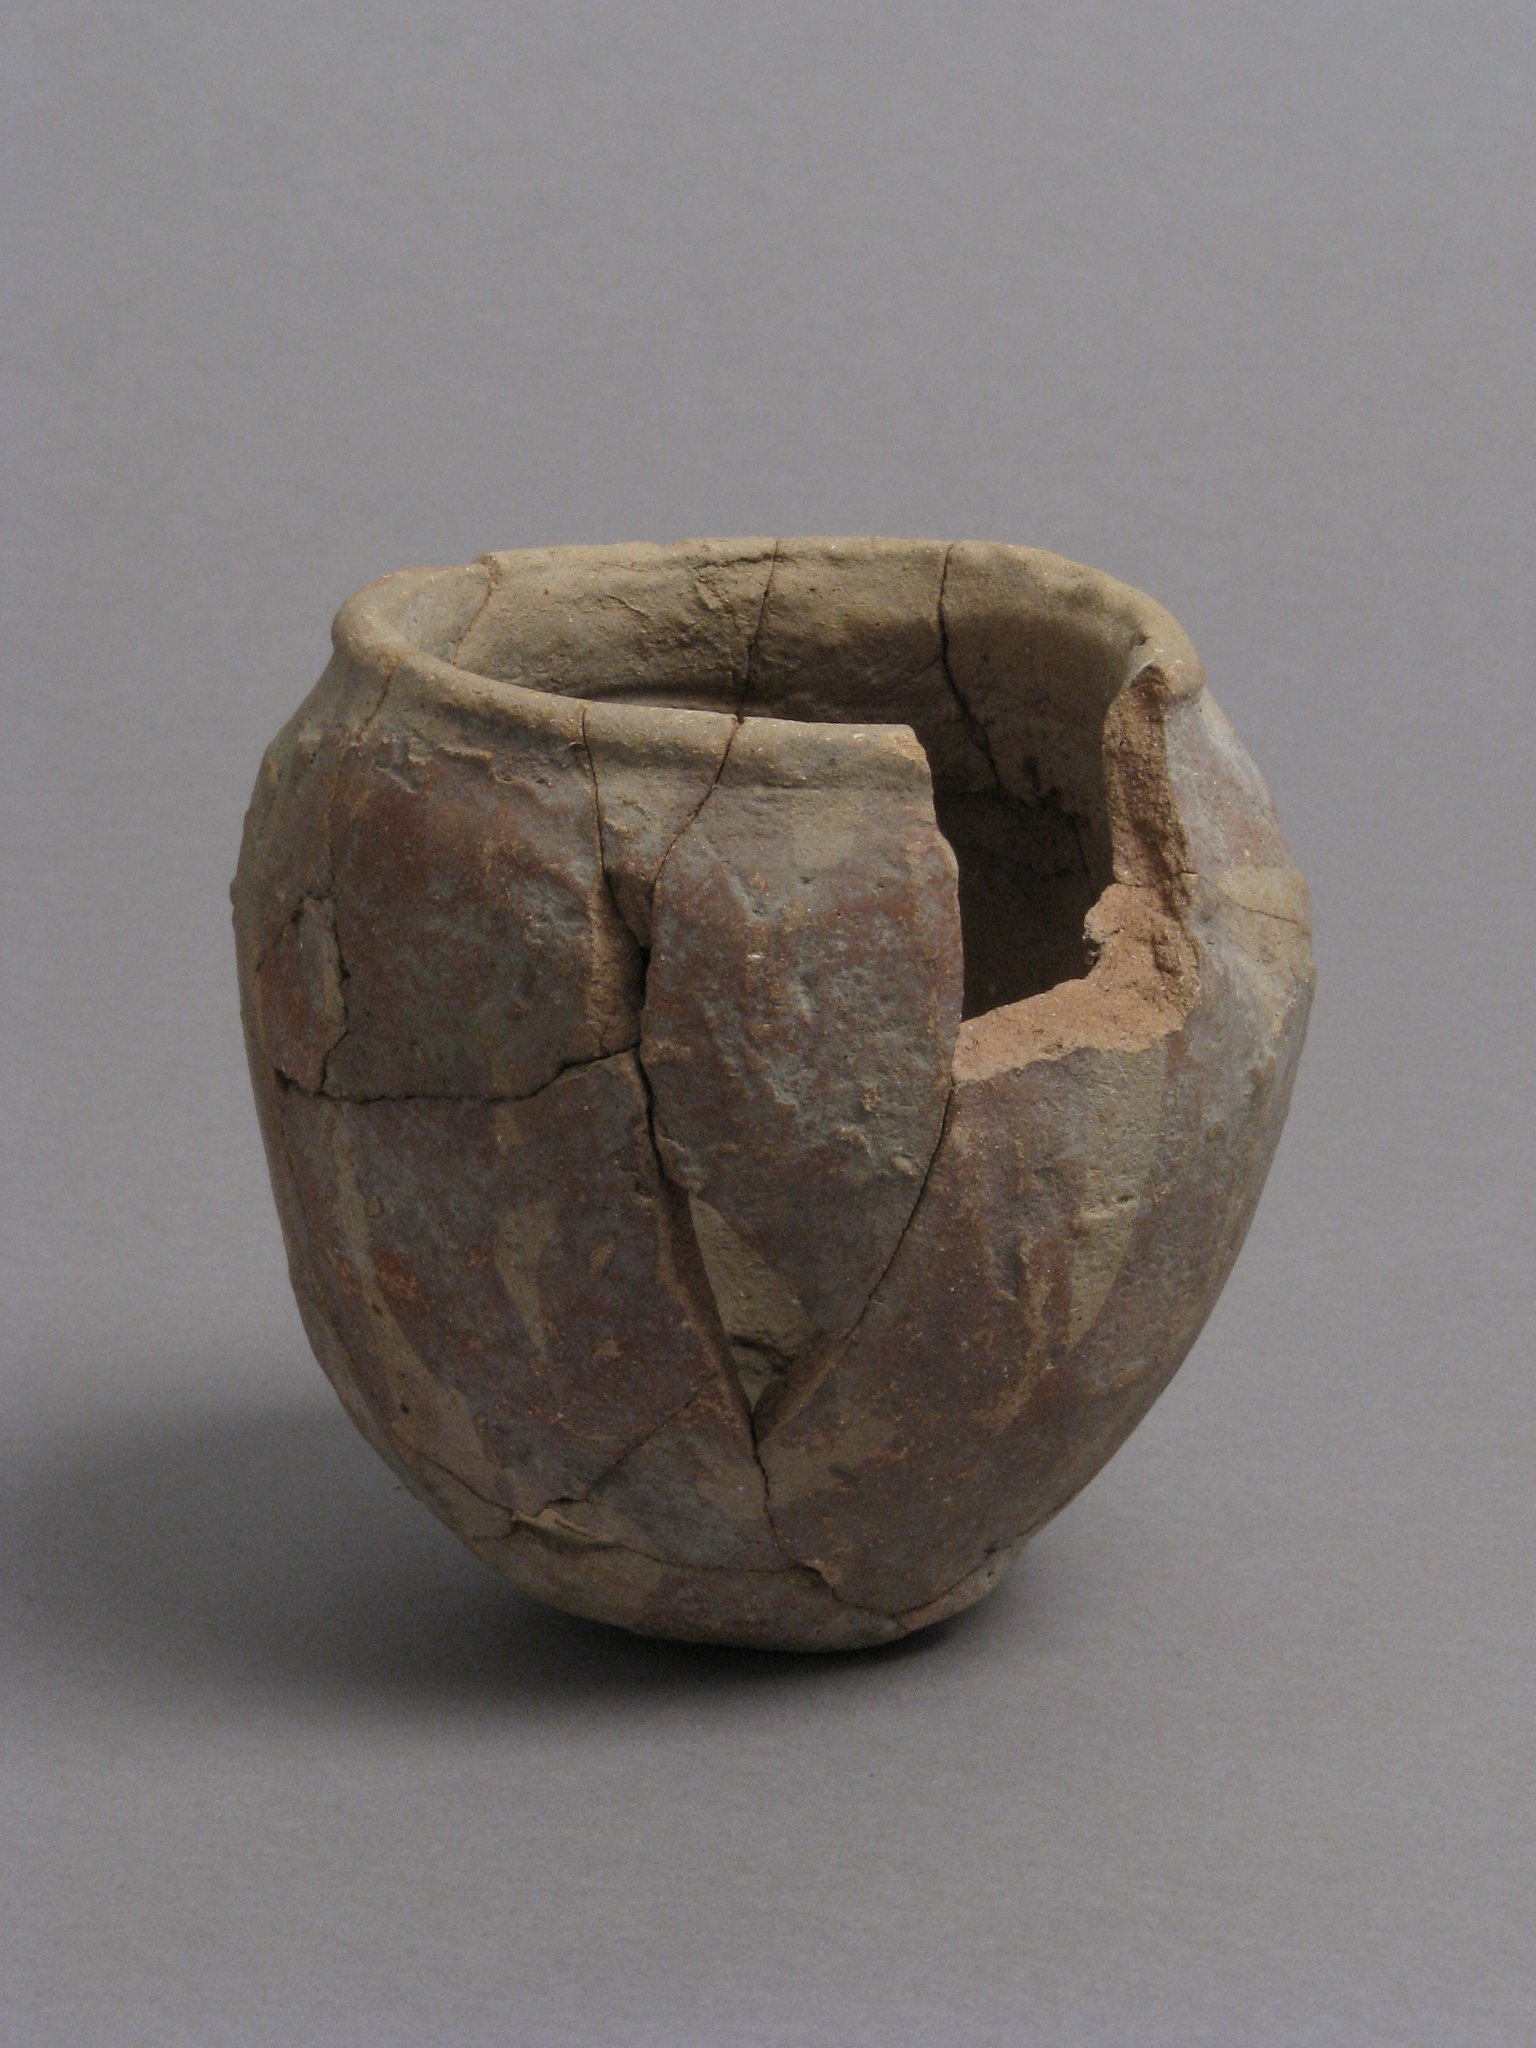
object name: pot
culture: coptic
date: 301-700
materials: earthenware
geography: egypt